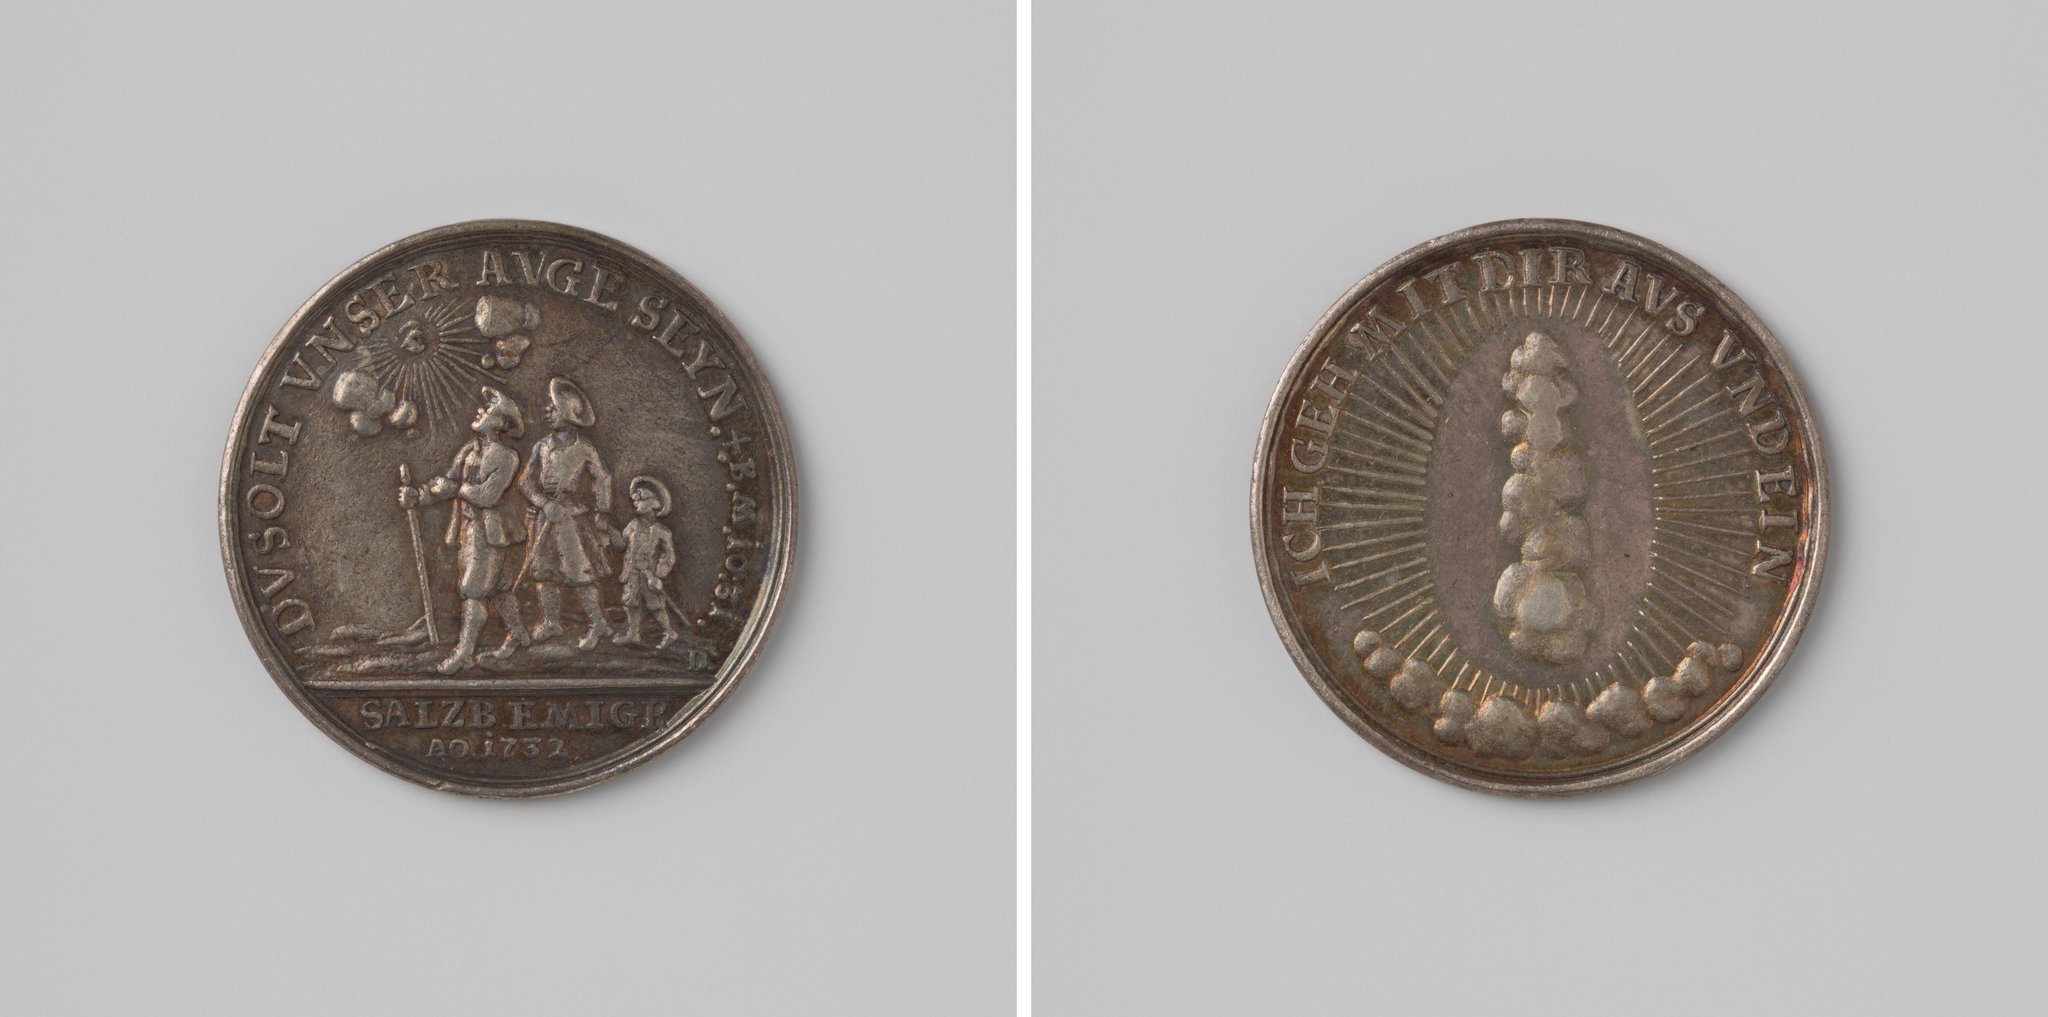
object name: history medal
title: Uittocht der Salzburger emigranten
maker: daniel sigismund dockler (ii)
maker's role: goldsmith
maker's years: 1667-1753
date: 1732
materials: silver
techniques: striking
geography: nuremberg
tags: drievuldigheidskerk, uittocht van salzburger emigranten (1732)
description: Zilveren penning. Voorzijde: man met stok, vrouw en kind binnen omschrift; afsnede: opschrift. Keerzijde: wolken binnen stralenkrans en omschrift